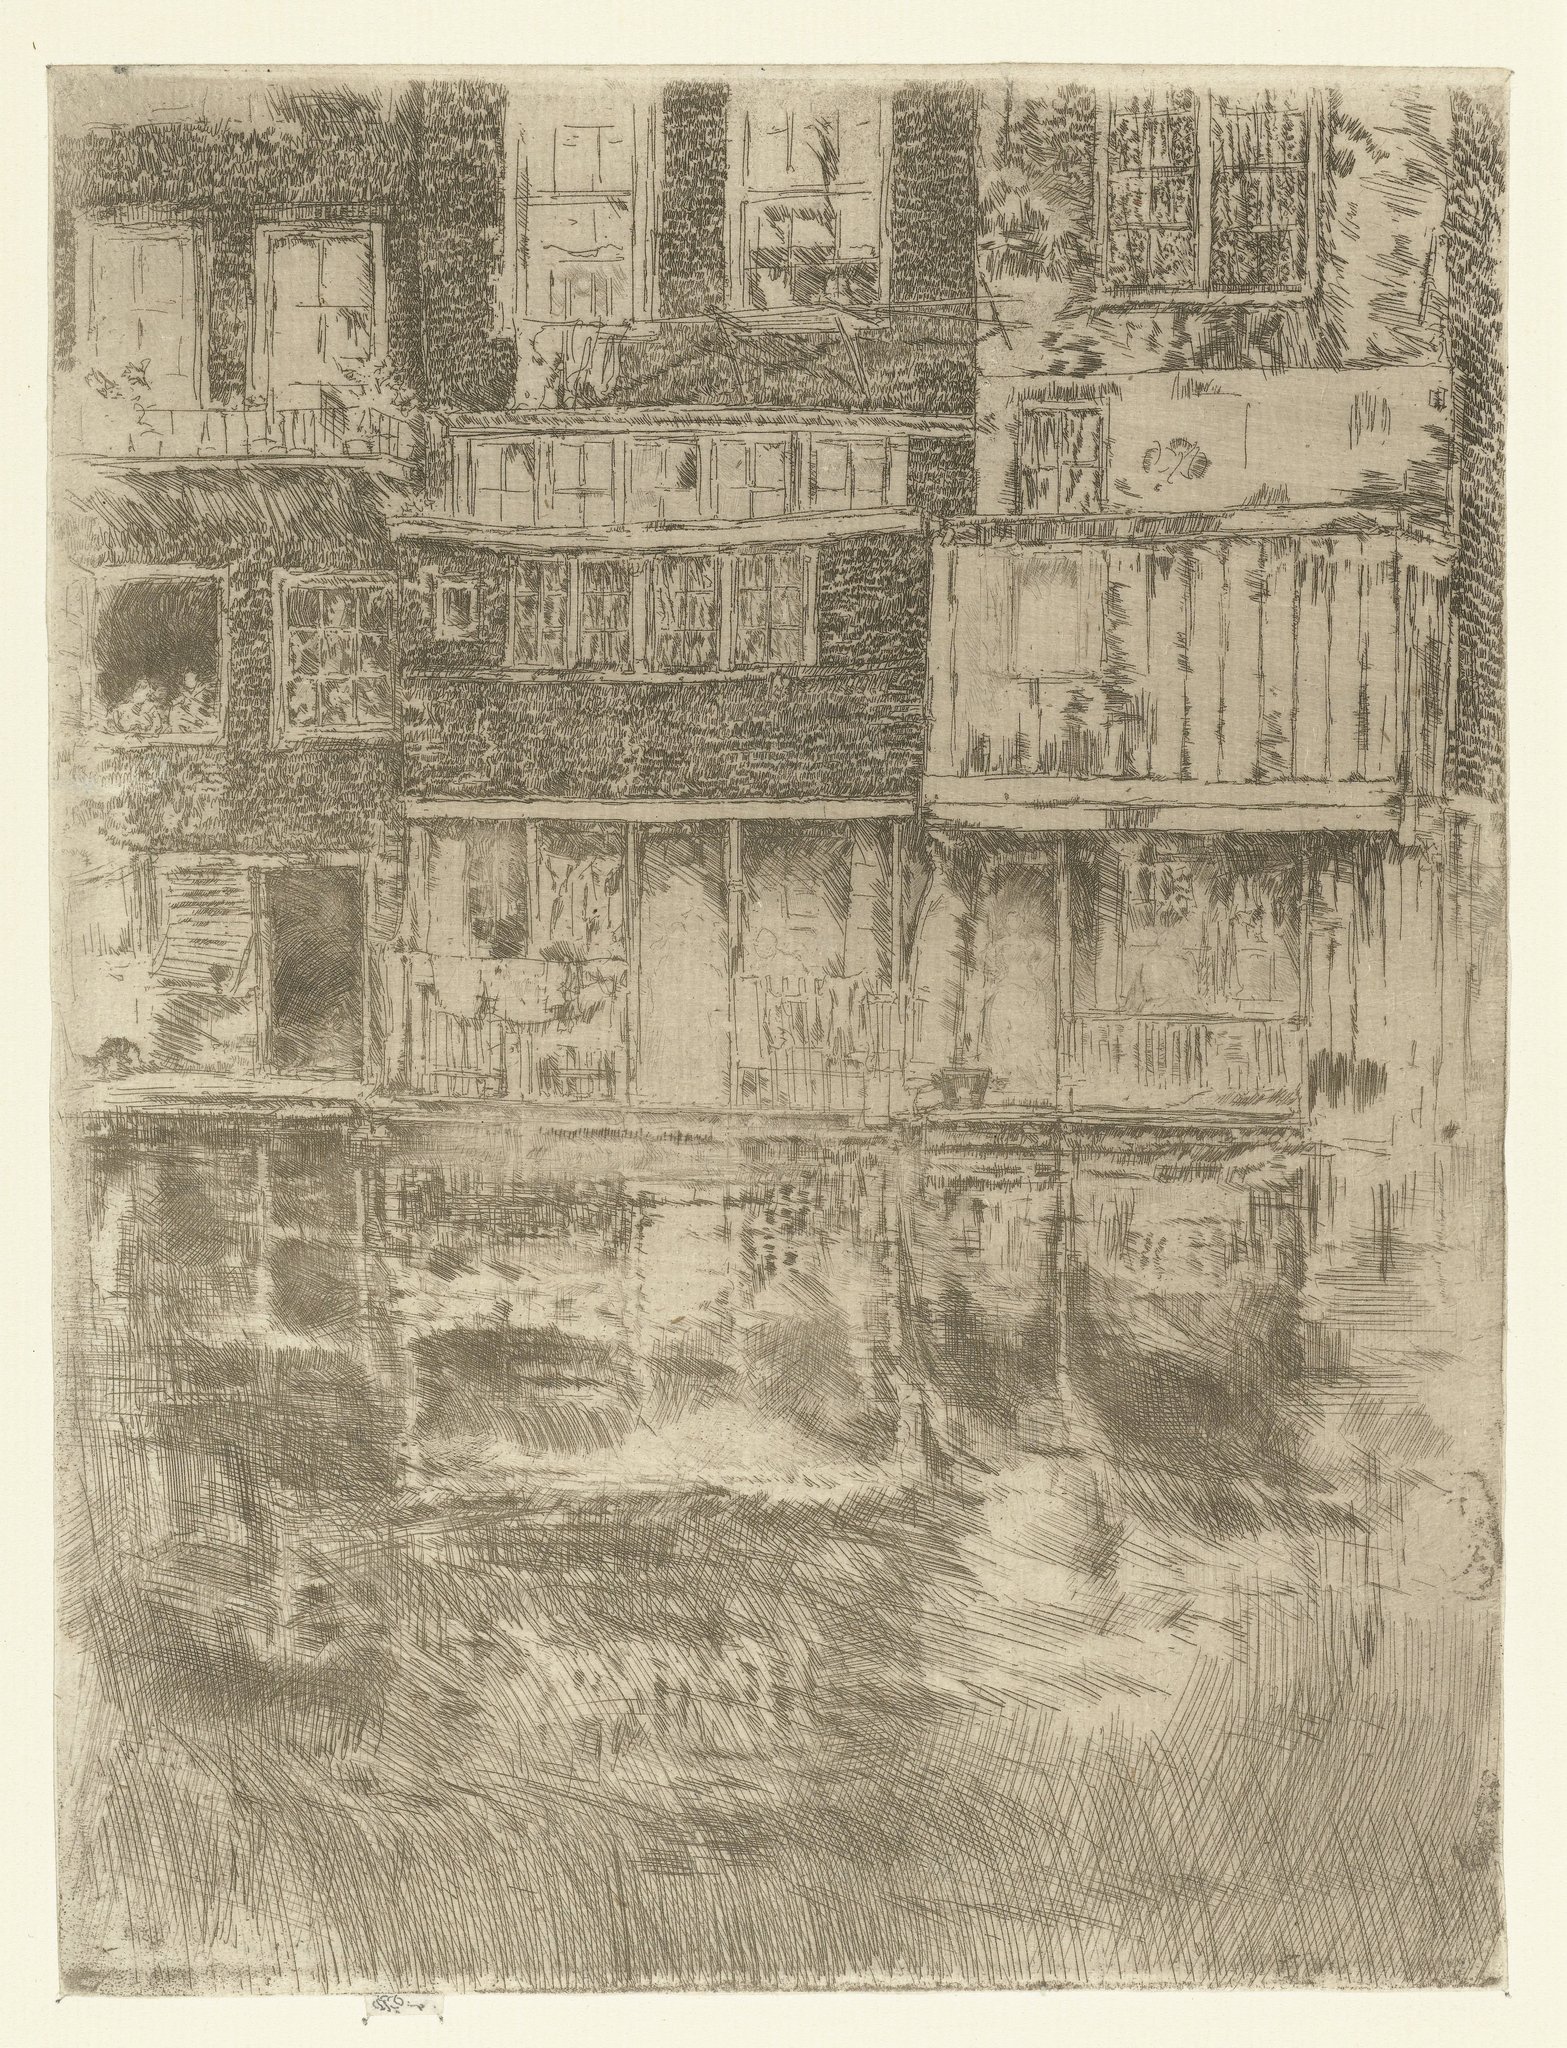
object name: print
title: Huizen in Amsterdam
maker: james abbott mcneill whistler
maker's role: painter, print maker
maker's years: 1834-1903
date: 1889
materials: paper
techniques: drypoint, etching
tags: the usual house or row of houses, amsterdam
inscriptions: collector's mark: Lugt 2228, signature: ‘JW imp’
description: Drie hoge smalle huizen in een rij aan het water in Amsterdam. Op een balkon en in een raam een aantal figuren.